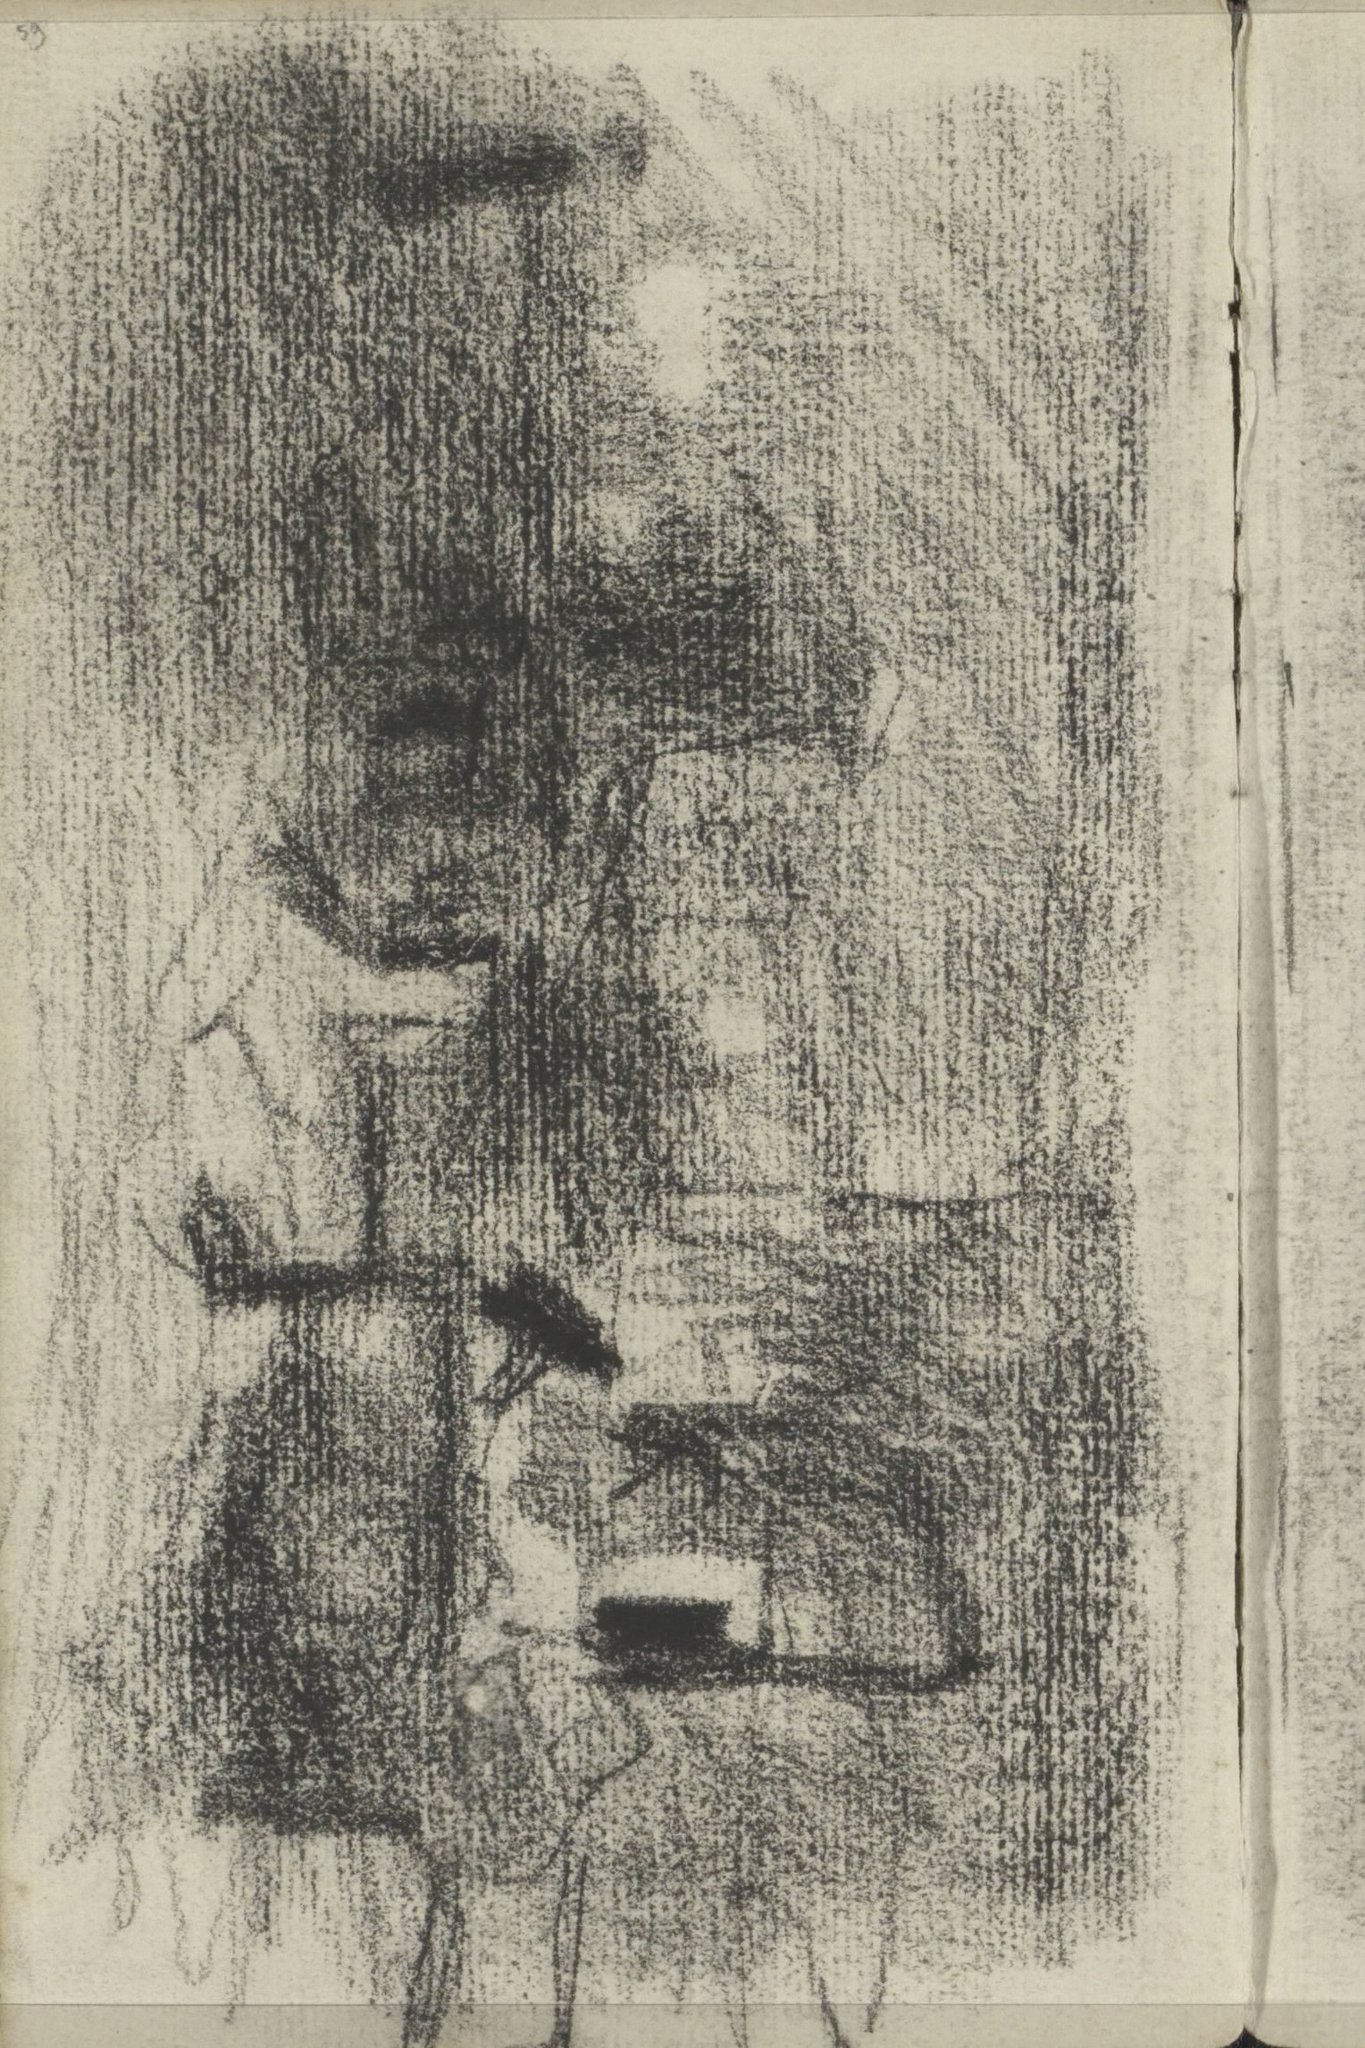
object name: sketchbook leaf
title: Twee figuren in een interieur, mogelijk een klasruimte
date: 1882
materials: chalk, paper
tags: writing-table, writing-desk, sitting figure, child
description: Pagina 59 uit een schetsboek met 31 bladen vervaardigd te Den Haag en Rotterdam.